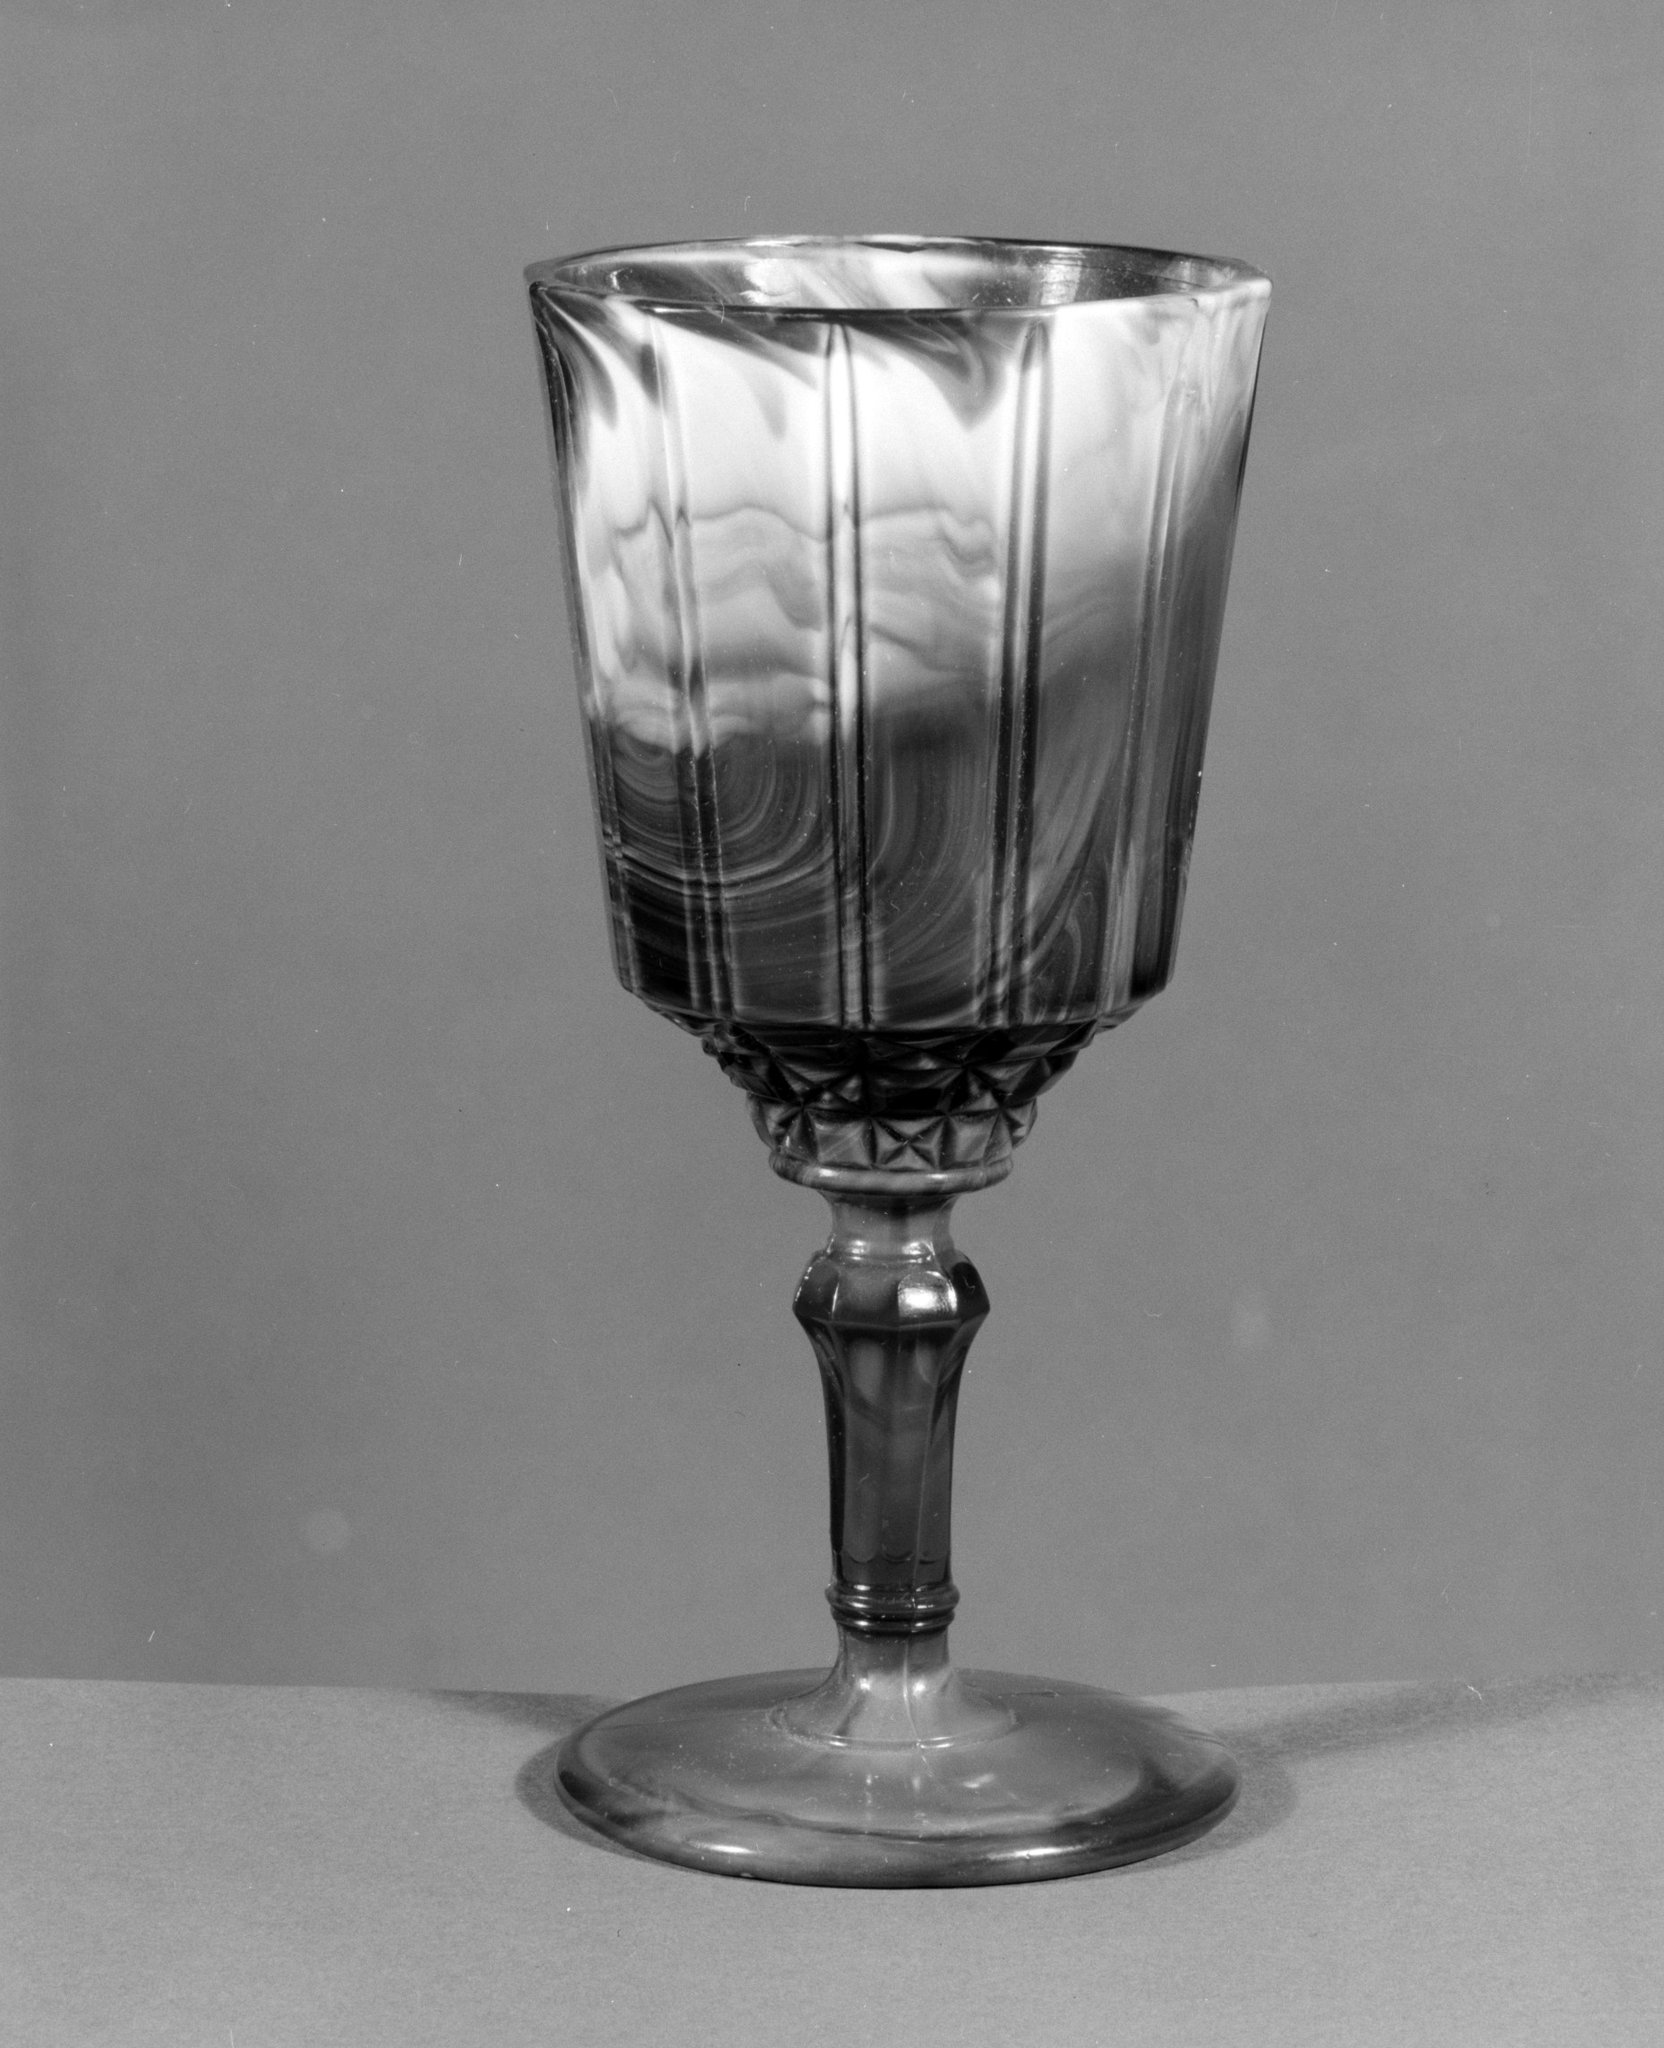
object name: goblet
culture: american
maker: challinor, taylor and company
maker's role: maker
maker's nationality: american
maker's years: 1866-1891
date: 1870-1890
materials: glass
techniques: pressed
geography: united states